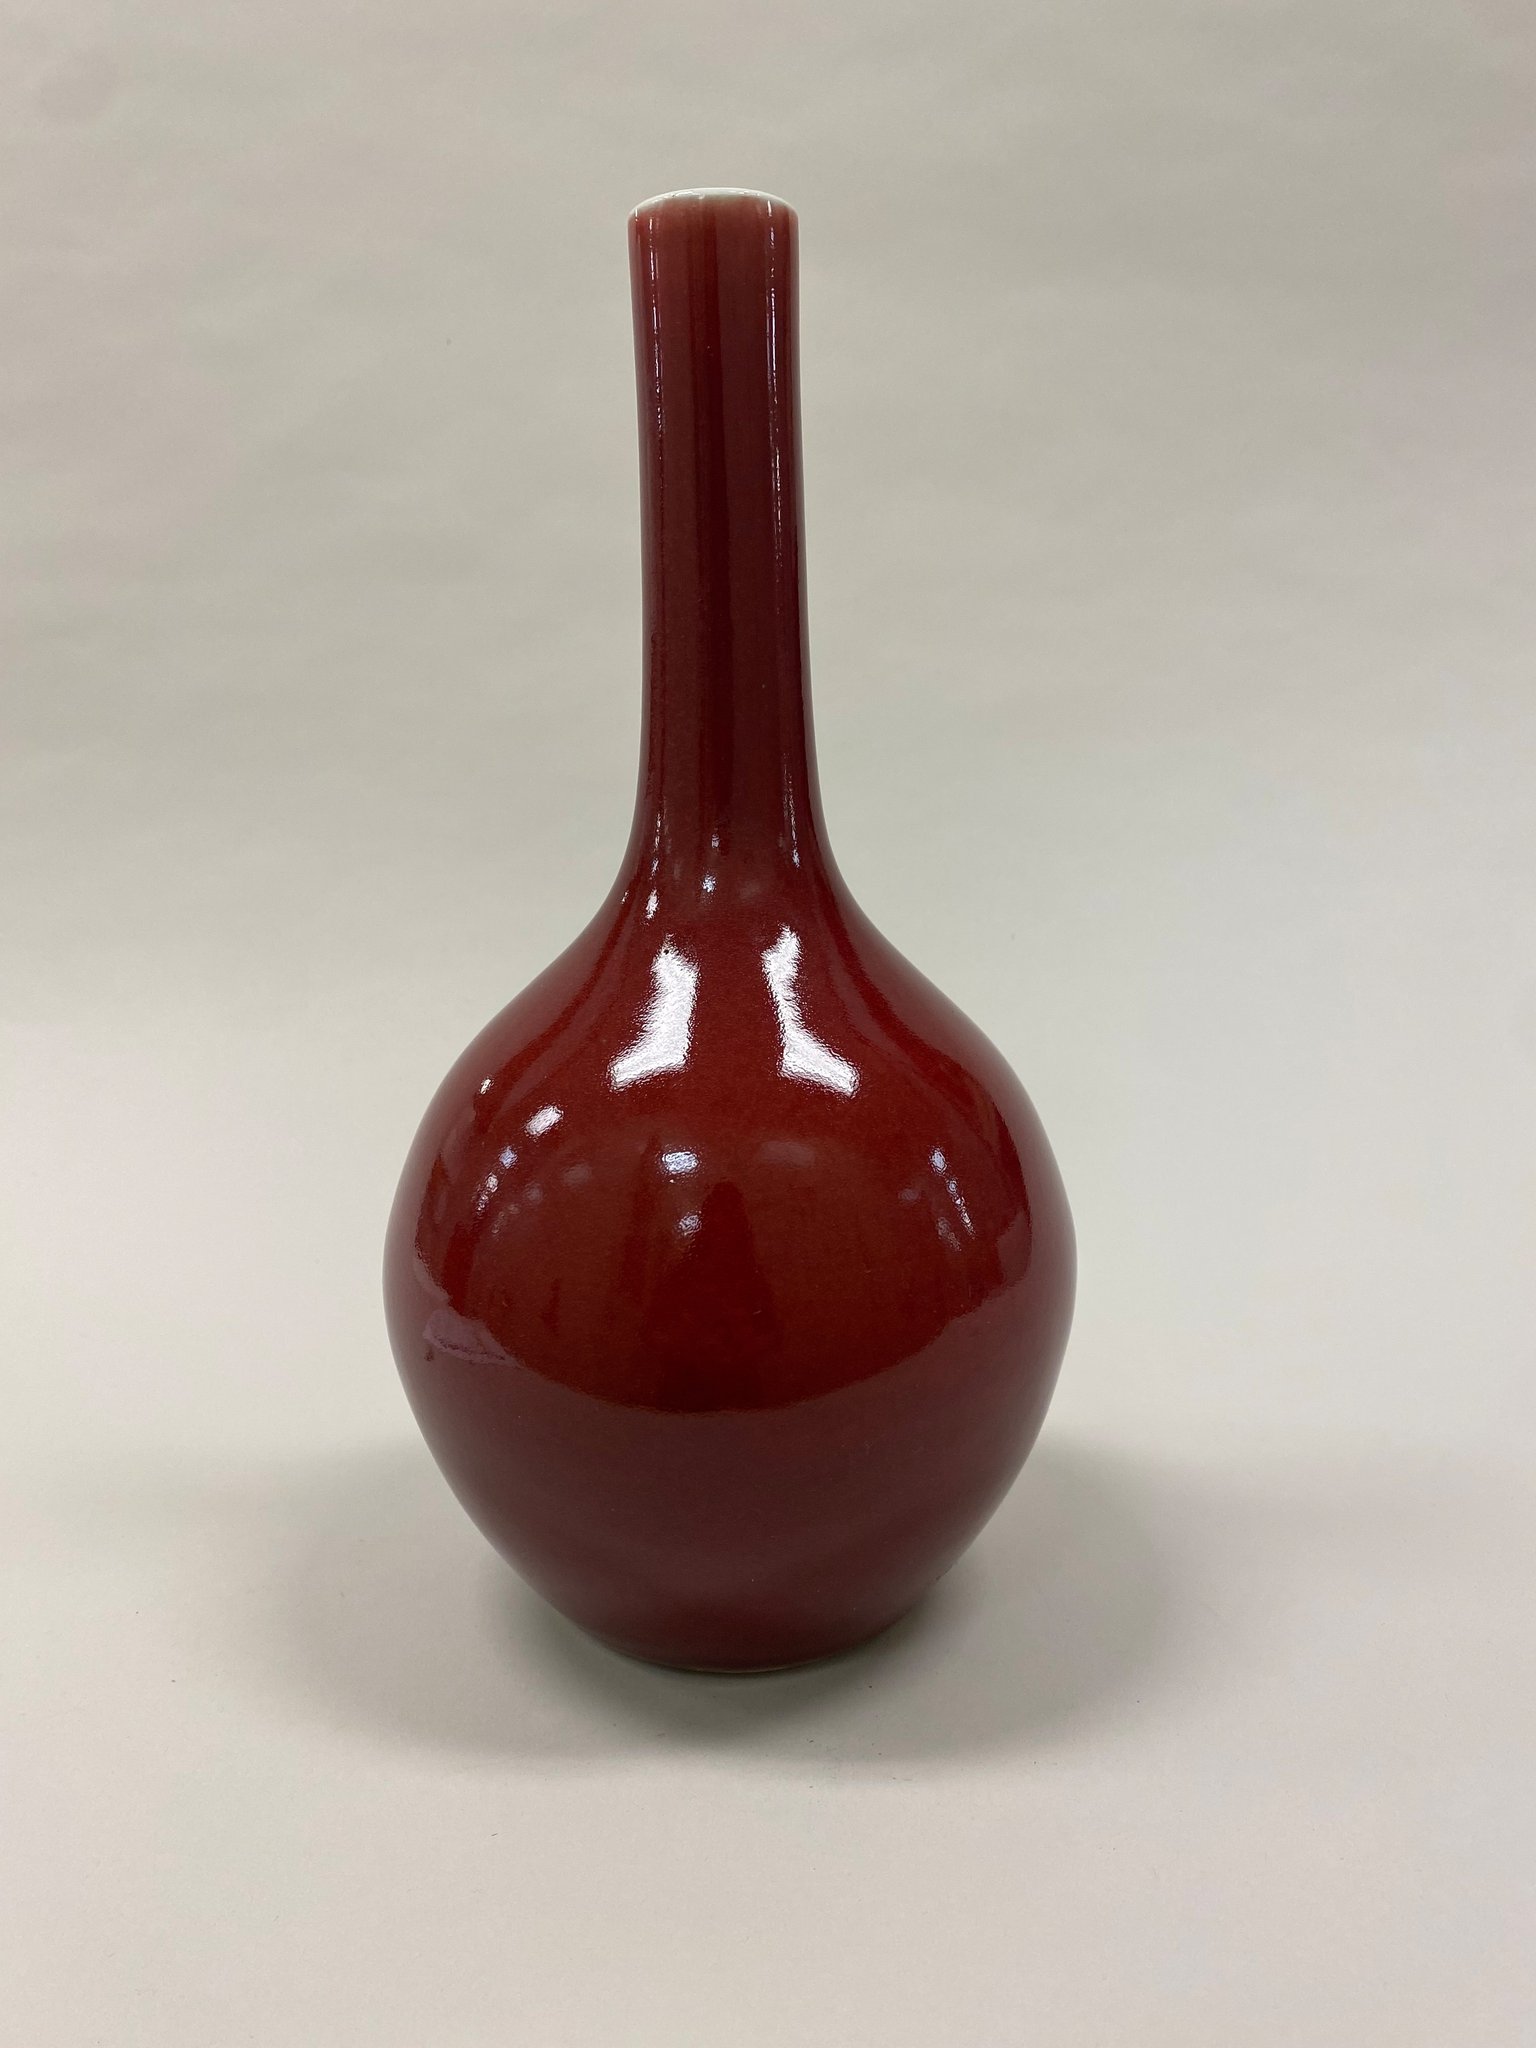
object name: bottle vase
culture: chinese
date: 1701-1800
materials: copper, glaze, porcelain